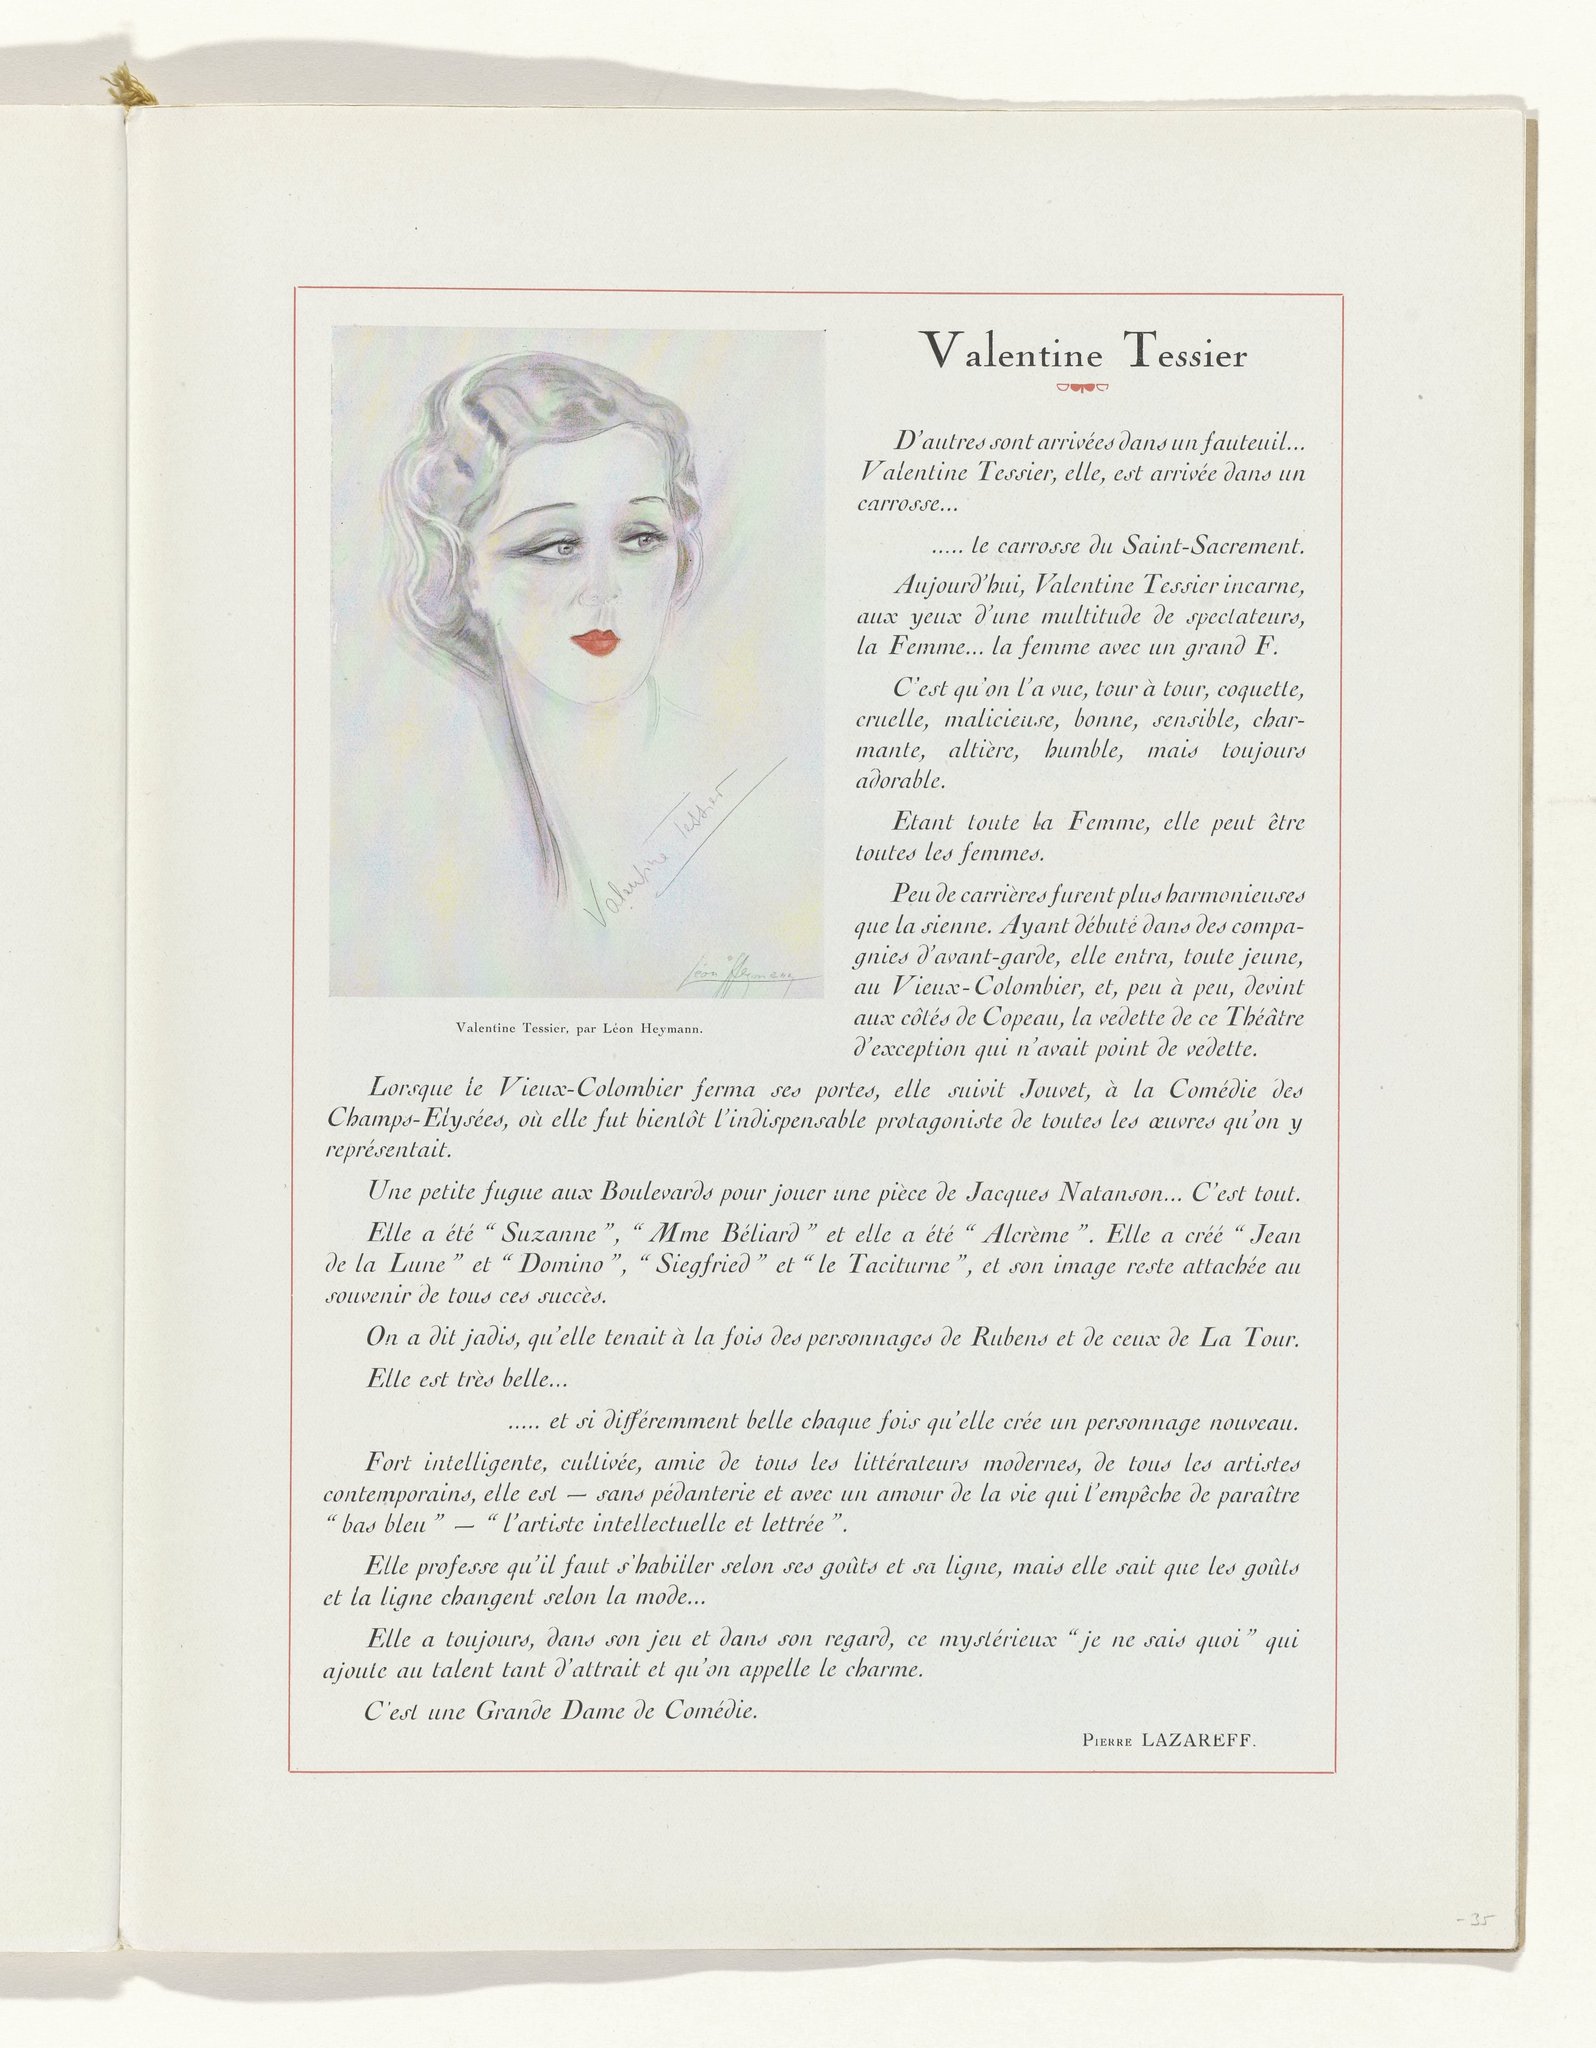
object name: magazine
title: Art - Goût - Beauté, Feuillets de l' élégance féminine, Juin 1932, No. 142, 12e Année, p. 35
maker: henri rouit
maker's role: publisher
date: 1932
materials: paper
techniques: printing, photography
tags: fashion plates, portrait of actor, actress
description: Tekst 'Valentine Tessier' met een afbeelding van de Franse actrice Valentine Tessier, getekend door Léon Heymann. Pagina uit het modetijdschrift Art-Goût-Beauté (1920-1933).